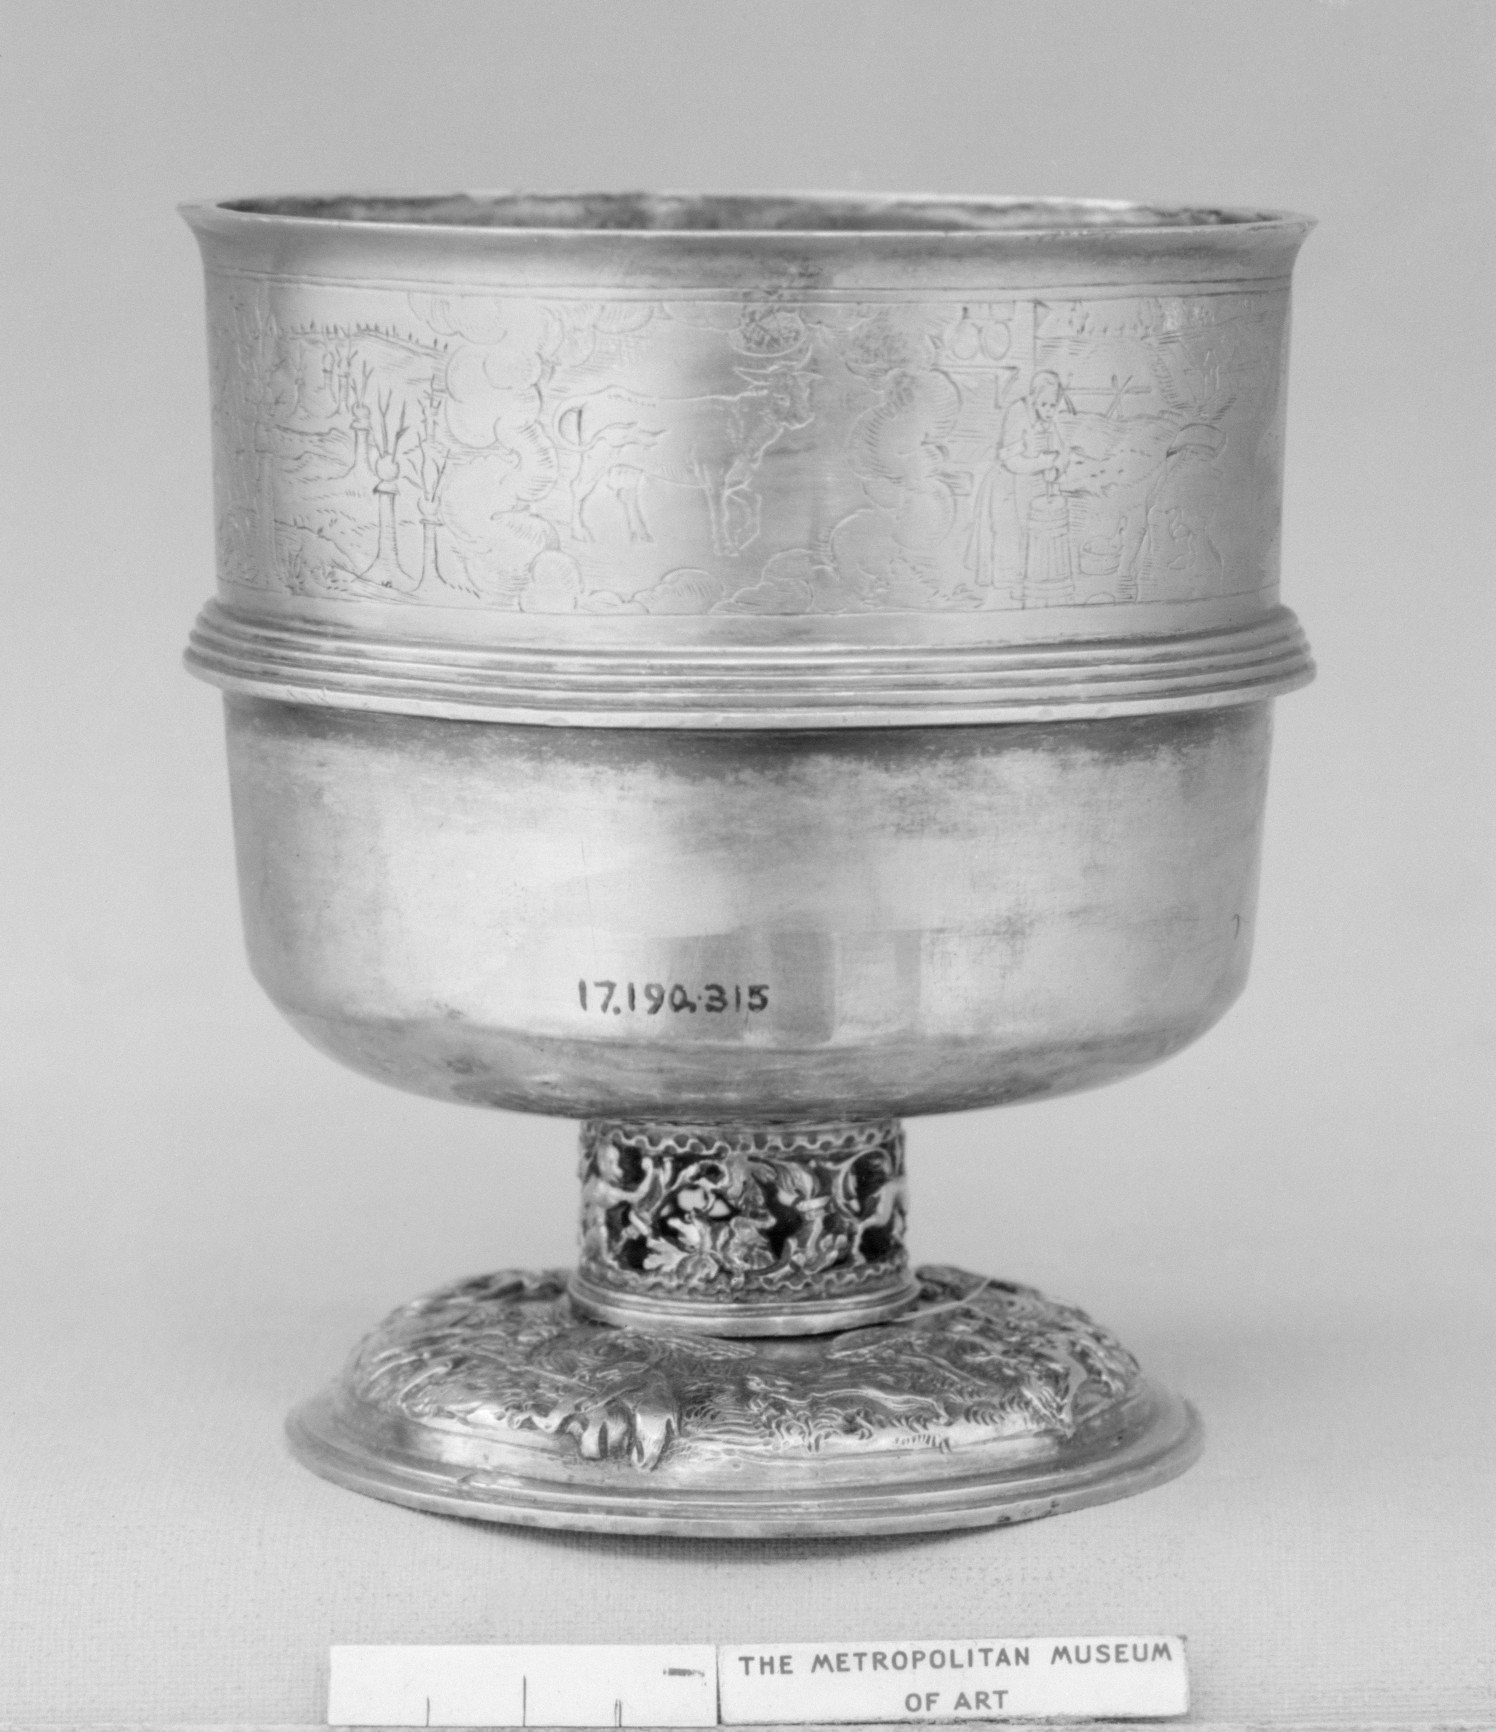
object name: cup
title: Cup (one of a set)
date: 1501-1600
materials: gilt, silver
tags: animals,women